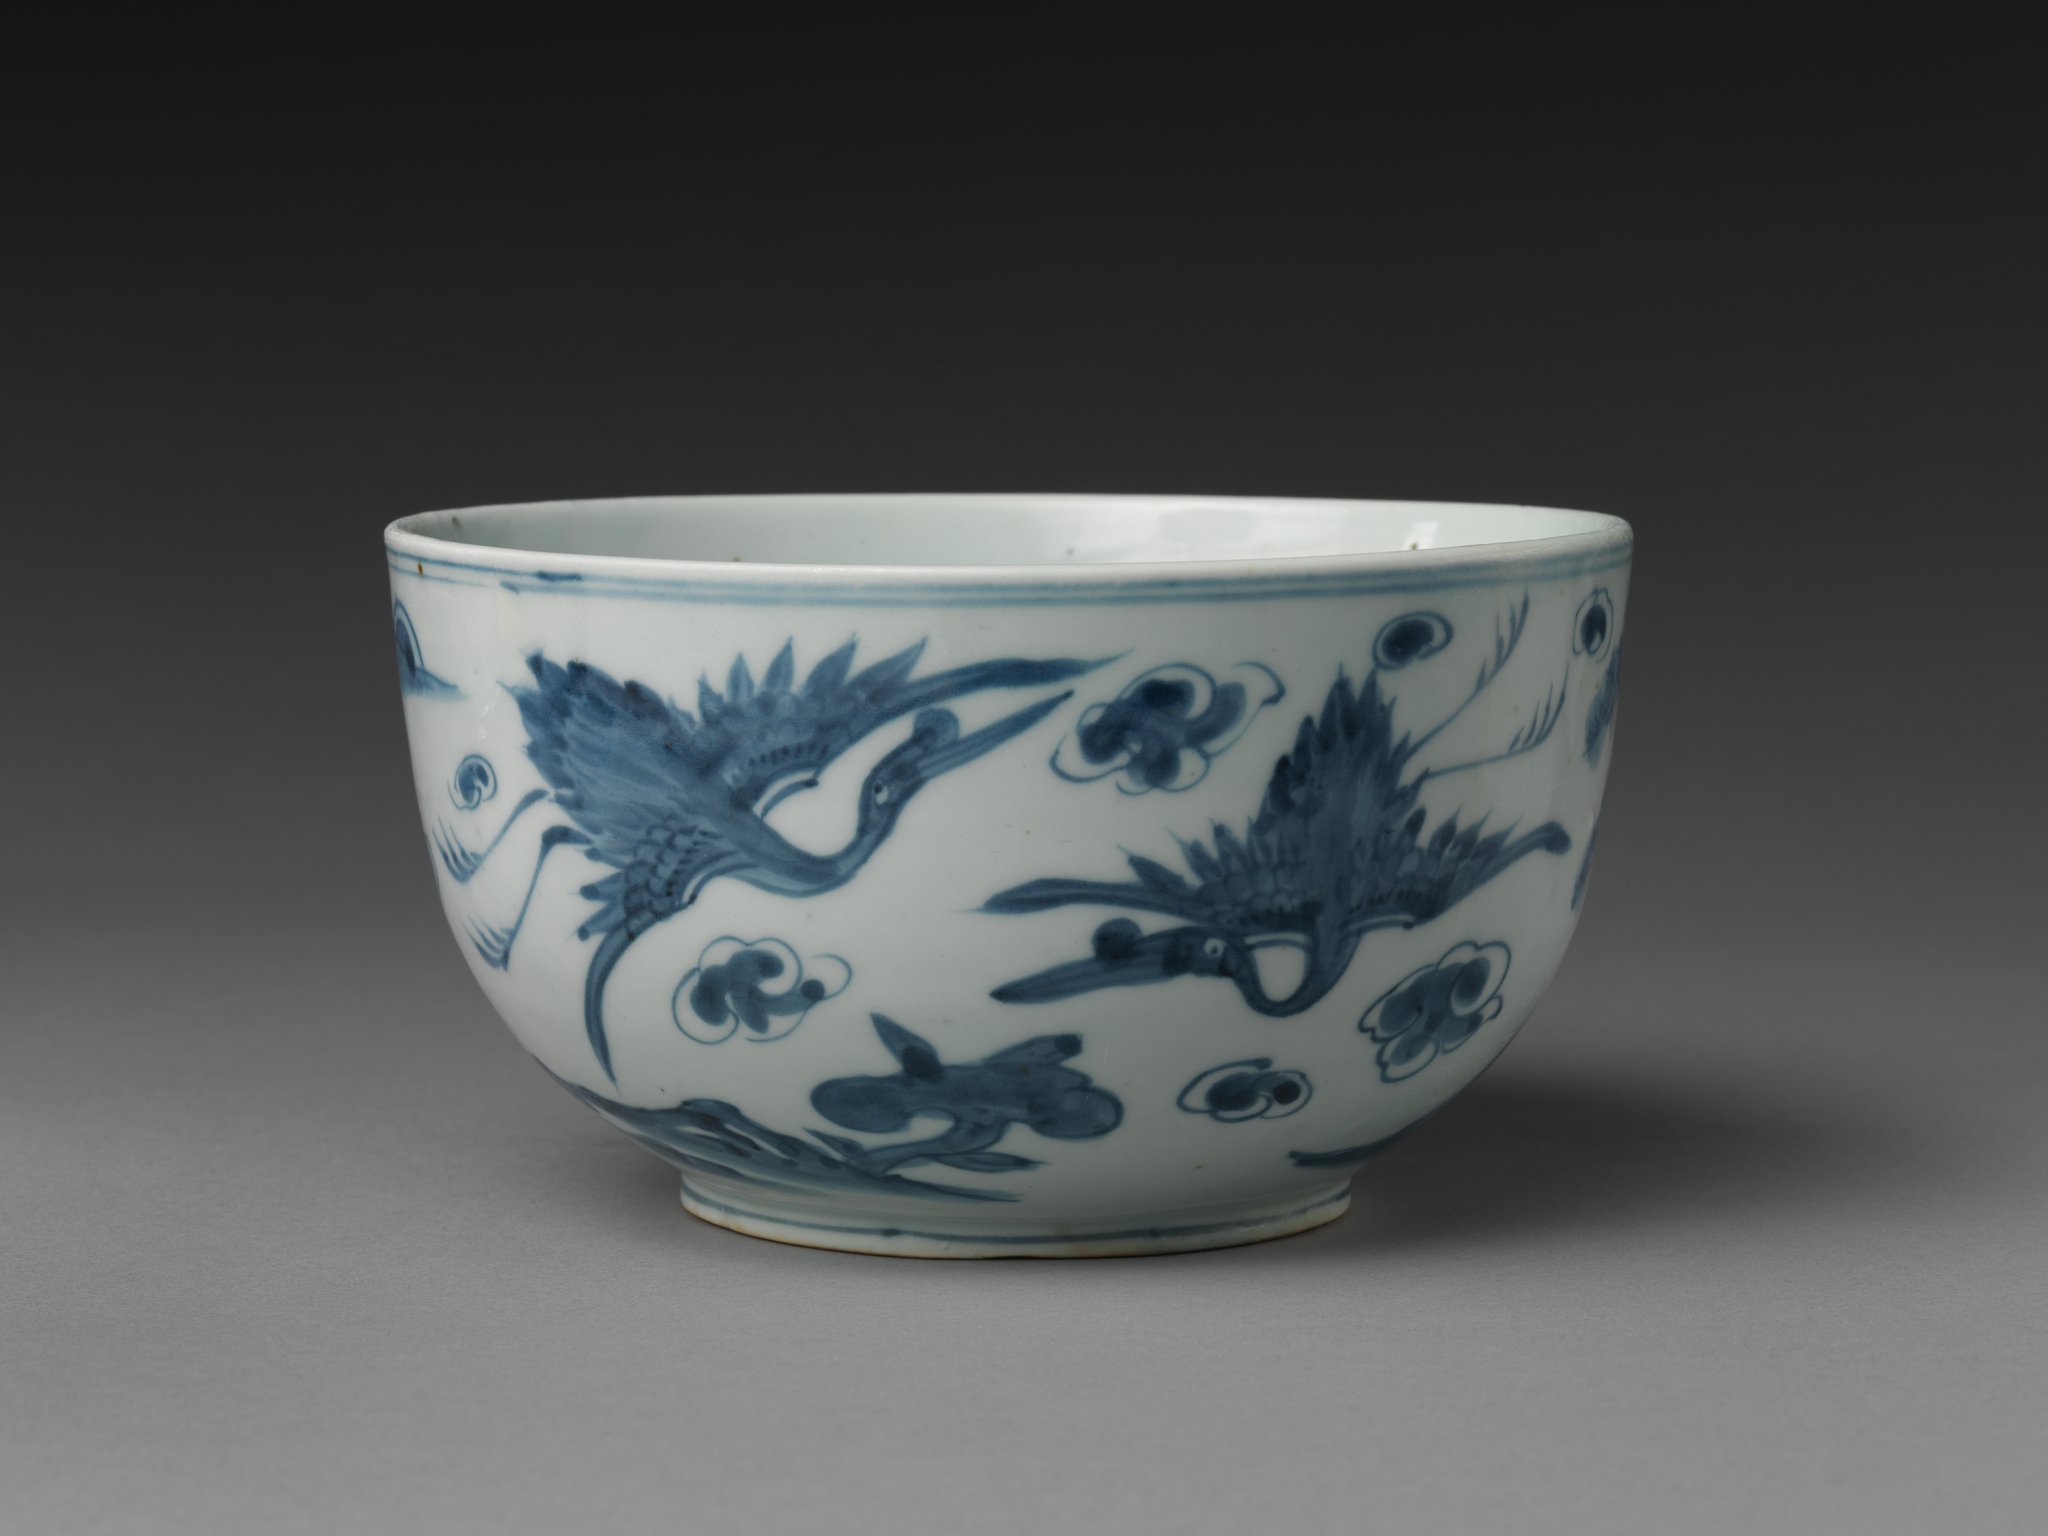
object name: bowl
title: Bowl decorated with the Ten Symbols of Longevity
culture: korean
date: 1801-1900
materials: cobalt, porcelain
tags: birds,deer